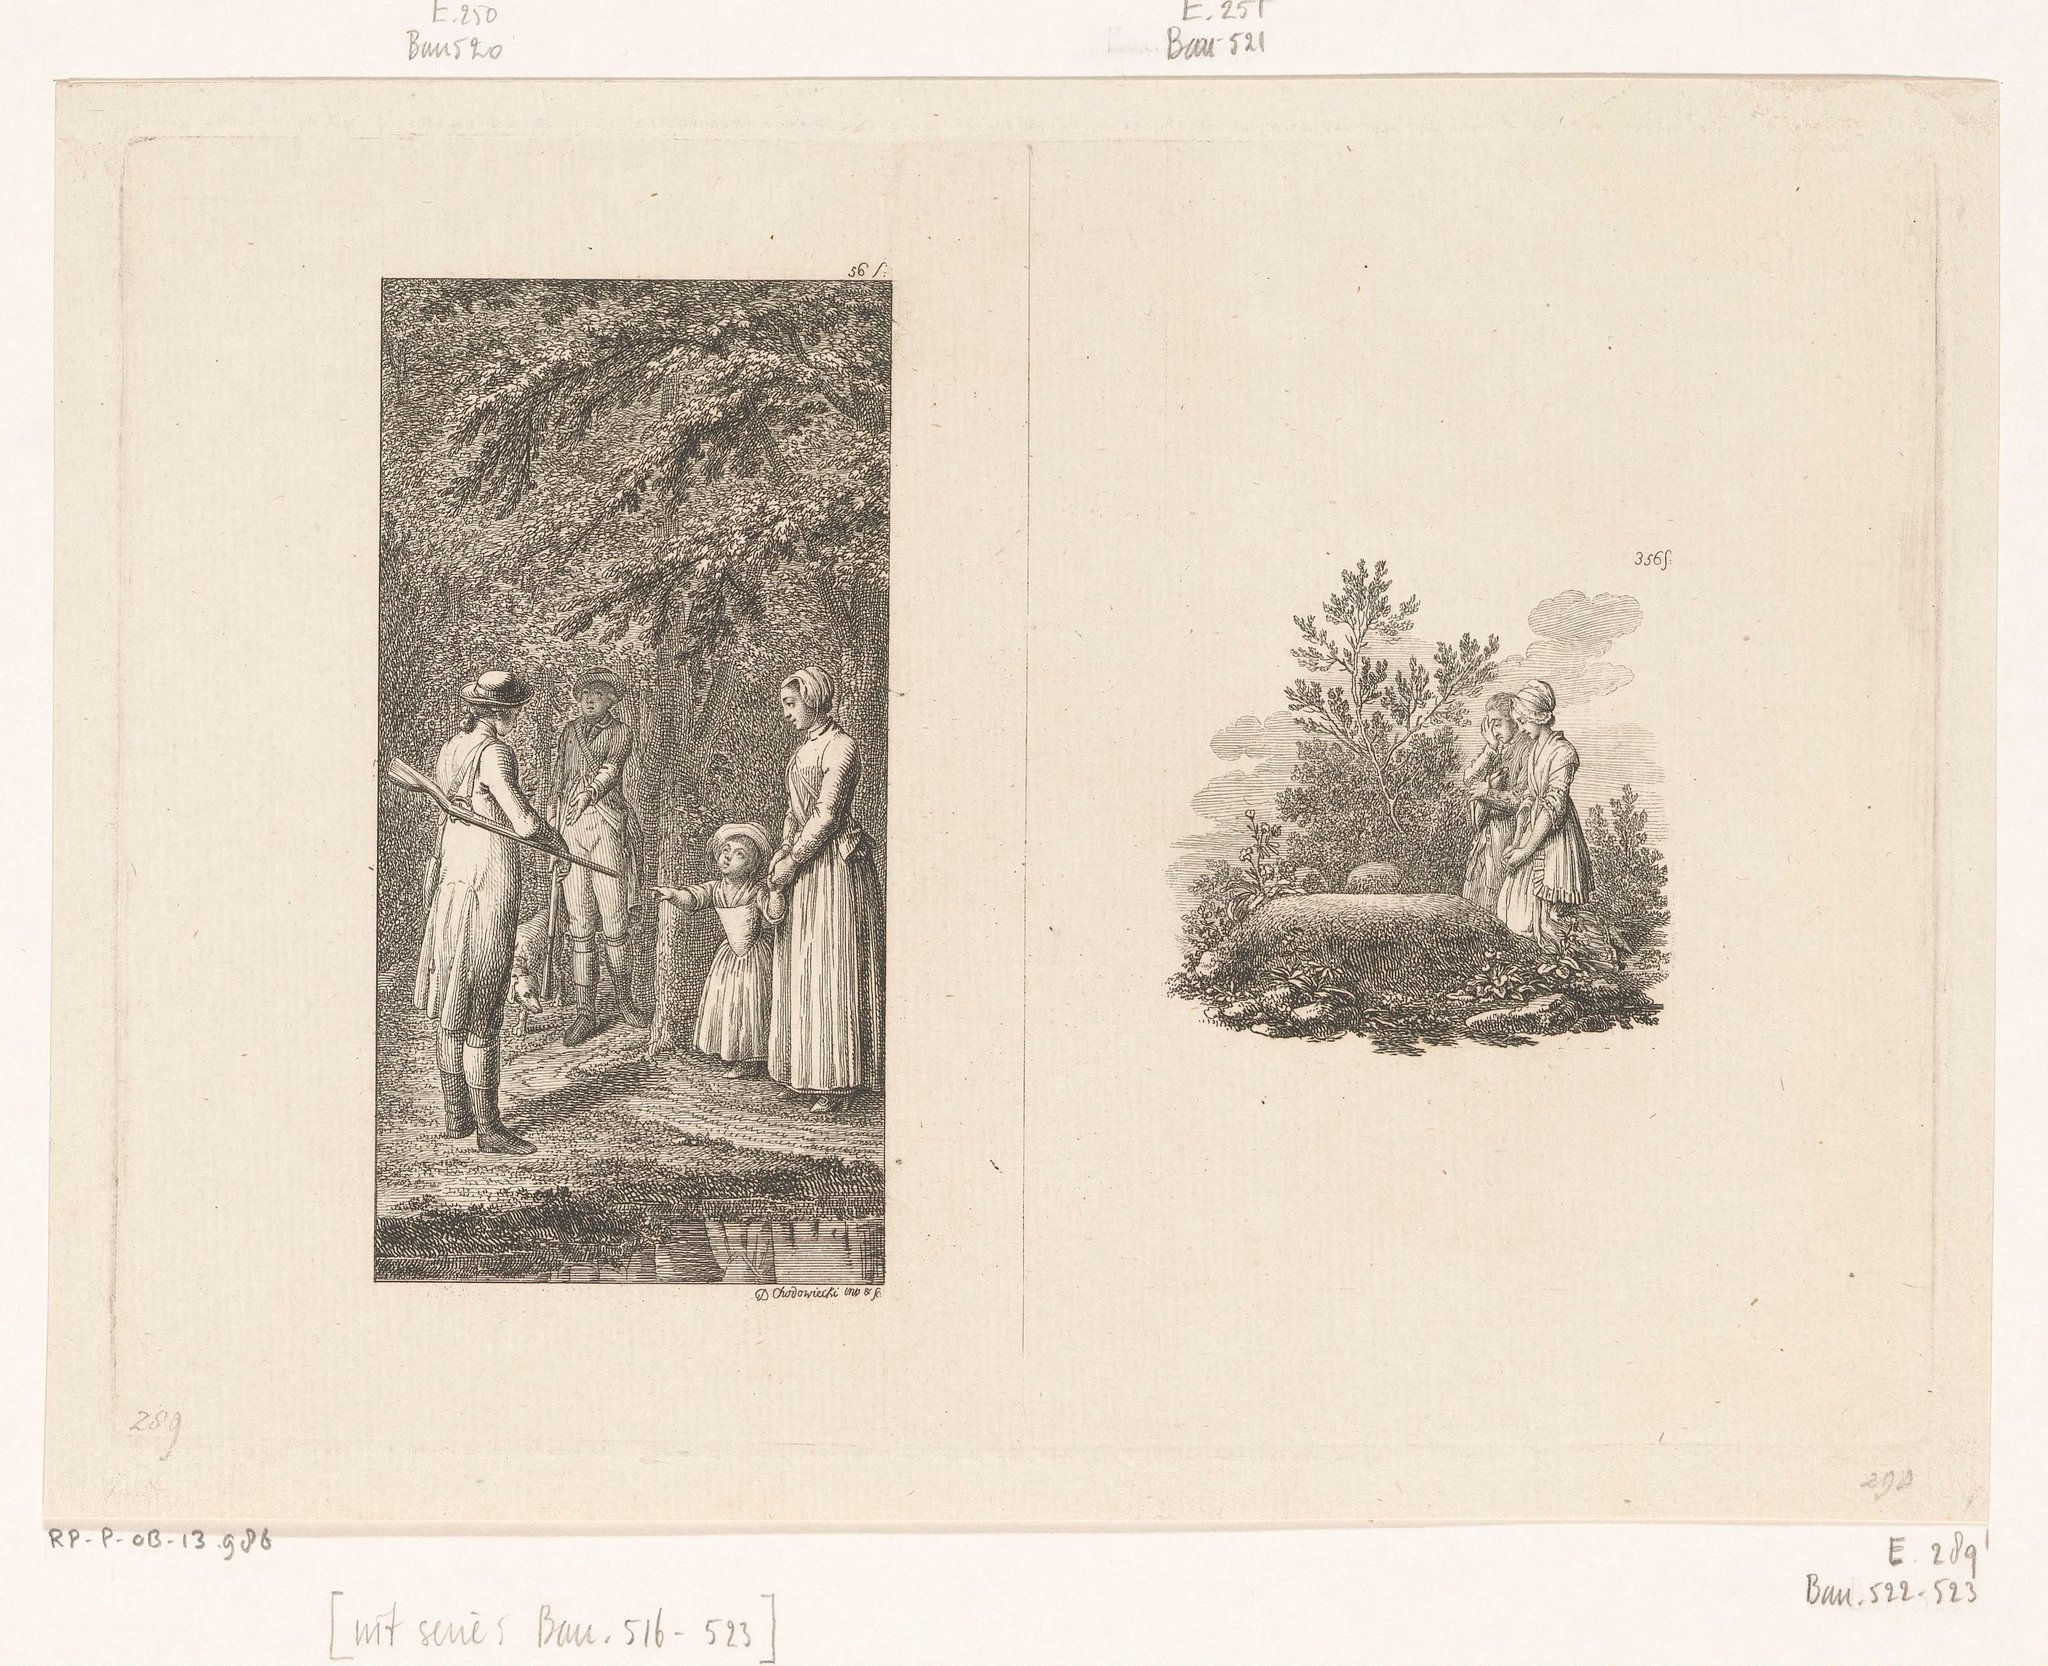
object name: print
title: Gotthard en Alexander op jacht en Mine en Benjamin bij het graf van hun moeder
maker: daniel nikolaus chodowiecki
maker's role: draughtsman, print maker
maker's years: 1726-1801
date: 1779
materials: paper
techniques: etching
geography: berlin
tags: literature, hunting, chase, grave, tomb, forest, wood, brothers or sisters (second degree family relationships)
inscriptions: collector's mark: Lugt 2228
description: Links een bosgezicht met vooraan Alexander en rechts Lorchen met haar oppas. Het kind heeft weer droge kleren aan, nadat Alexander het uit het water heeft gered. Uit het bos komt Gotthard tevoorschijn. Rechts staan Mine en Benjamin bij het graf van hun moeder